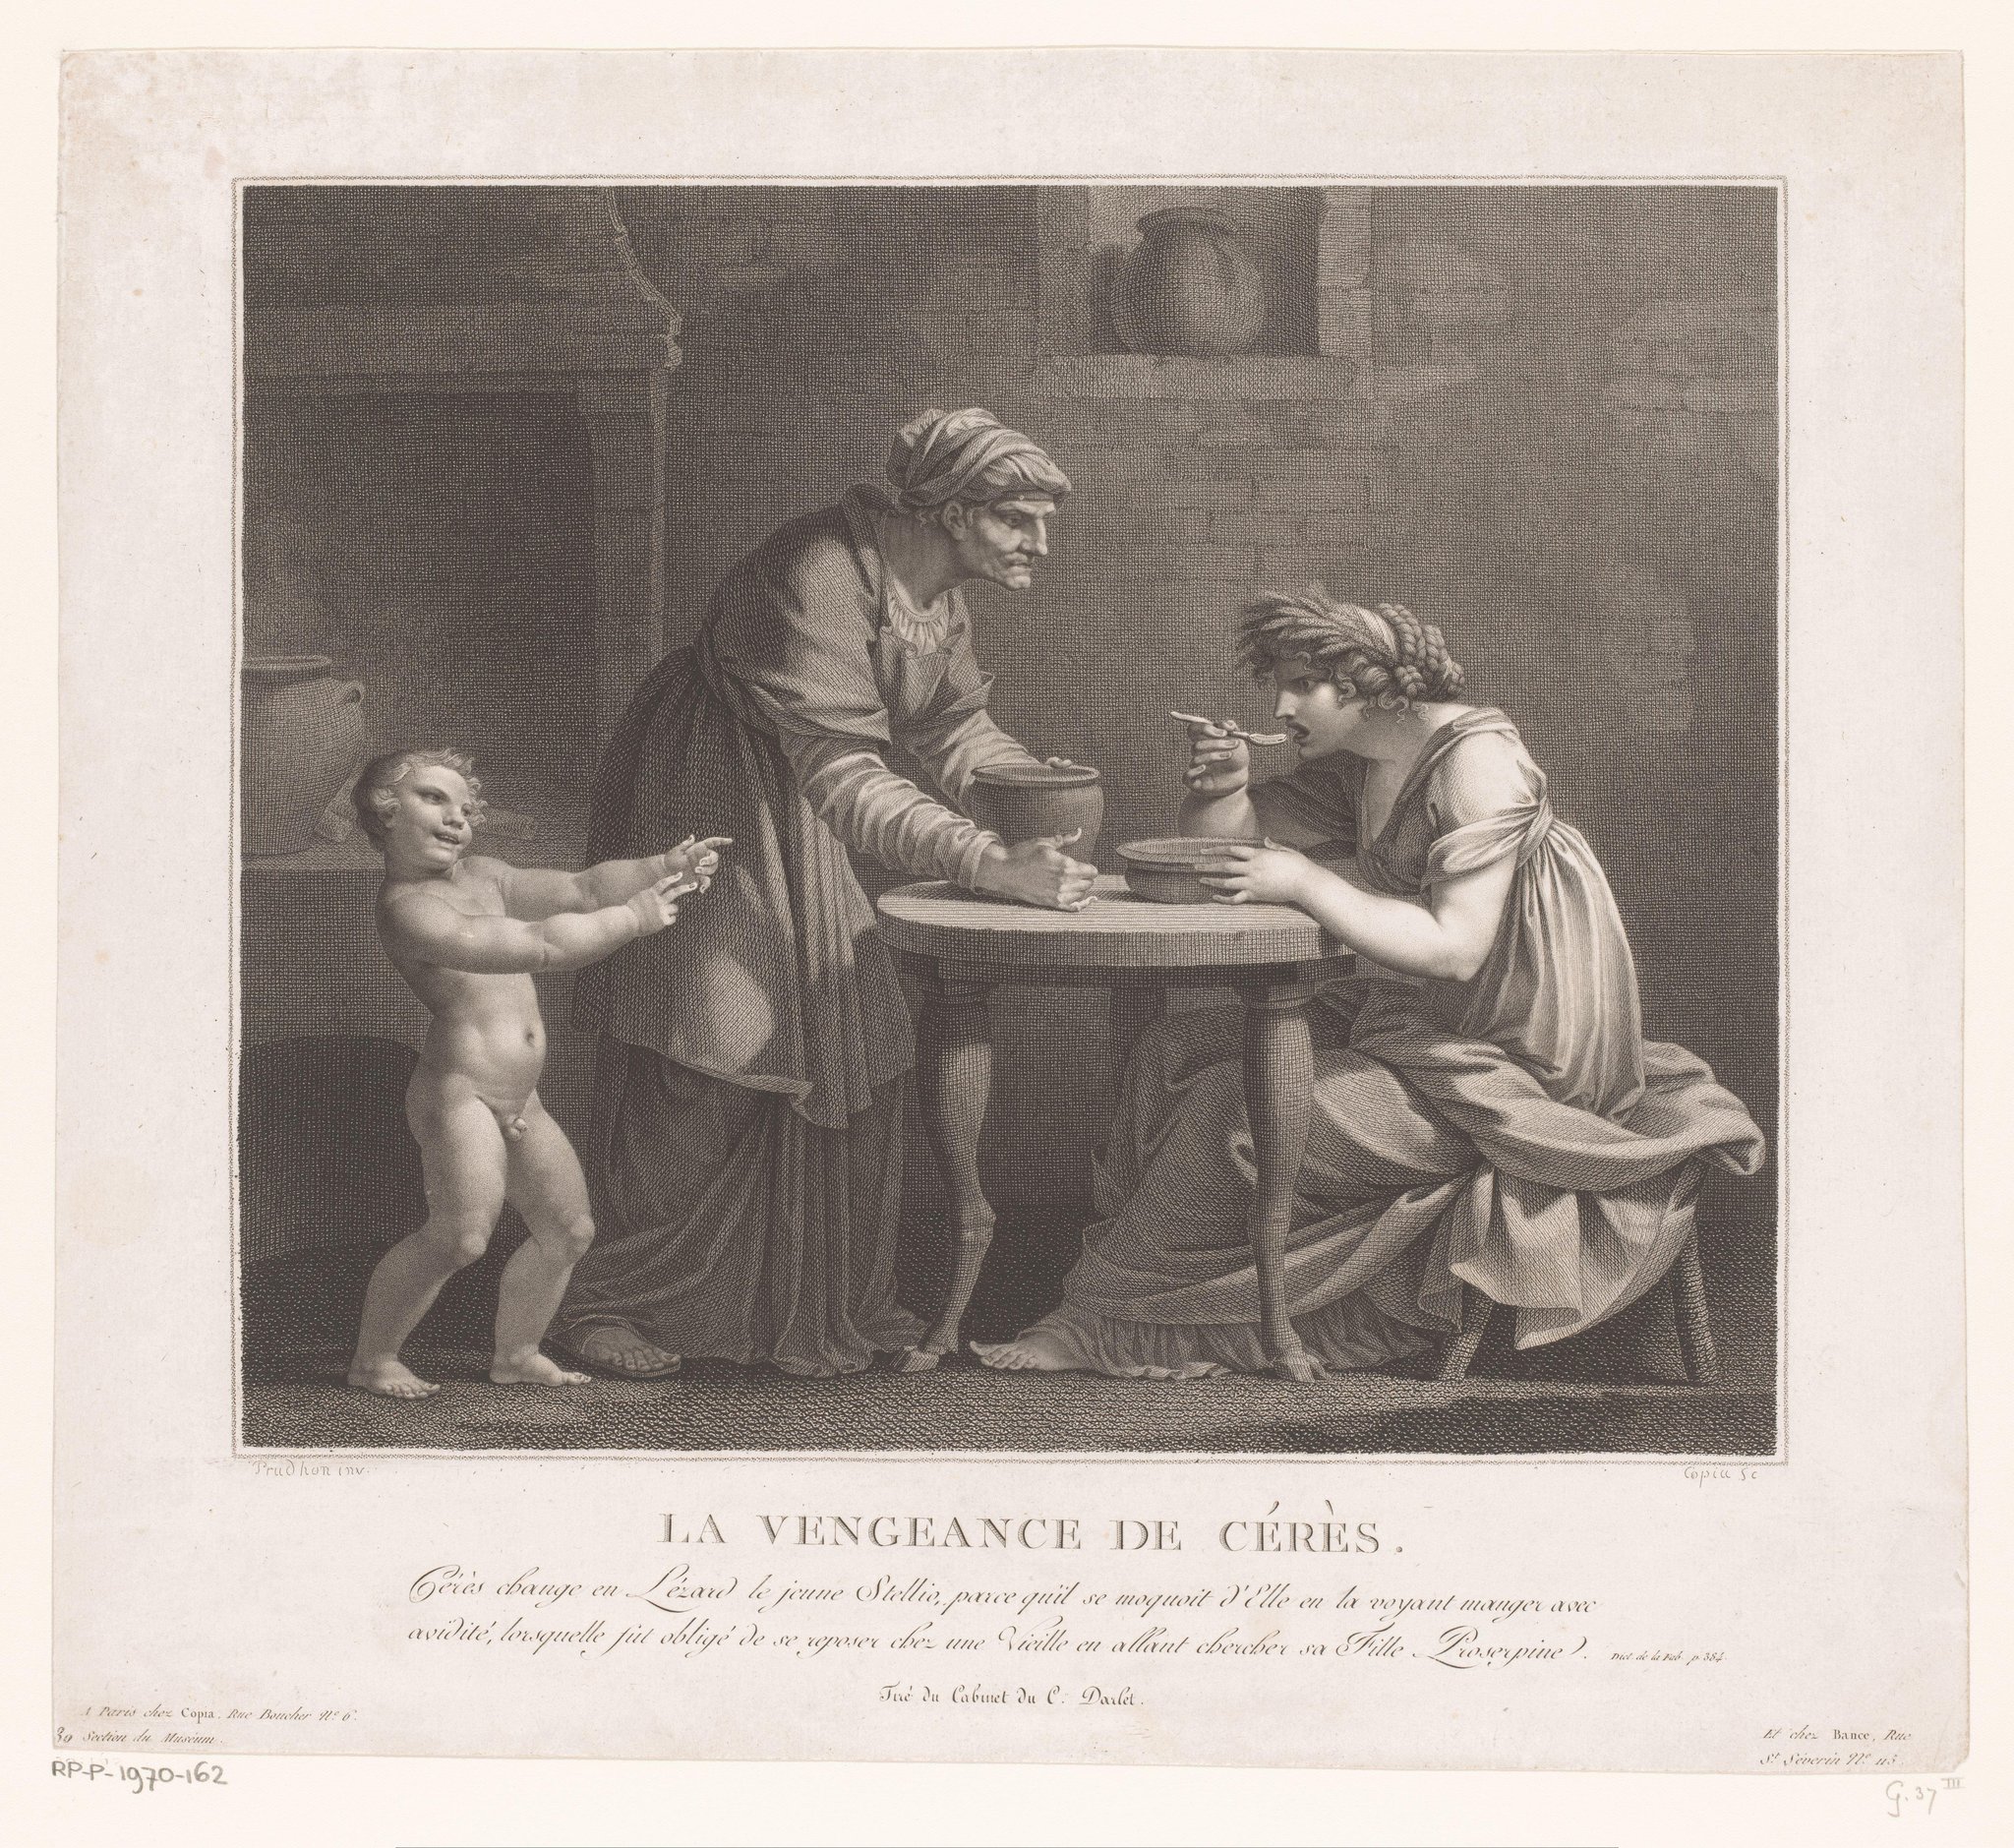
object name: print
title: La Vengeance de Ceres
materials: paper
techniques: engraving, etching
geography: paris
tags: ascalabus (stellio, abas) changed into a lizard: ceres changes the boy into a lizard as punishment for mocking her, when quenching her thirst too avidly (ovid, metamorphoses v 456)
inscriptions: collector's mark: Lugt 2760, collector's mark: Lugt 2228a